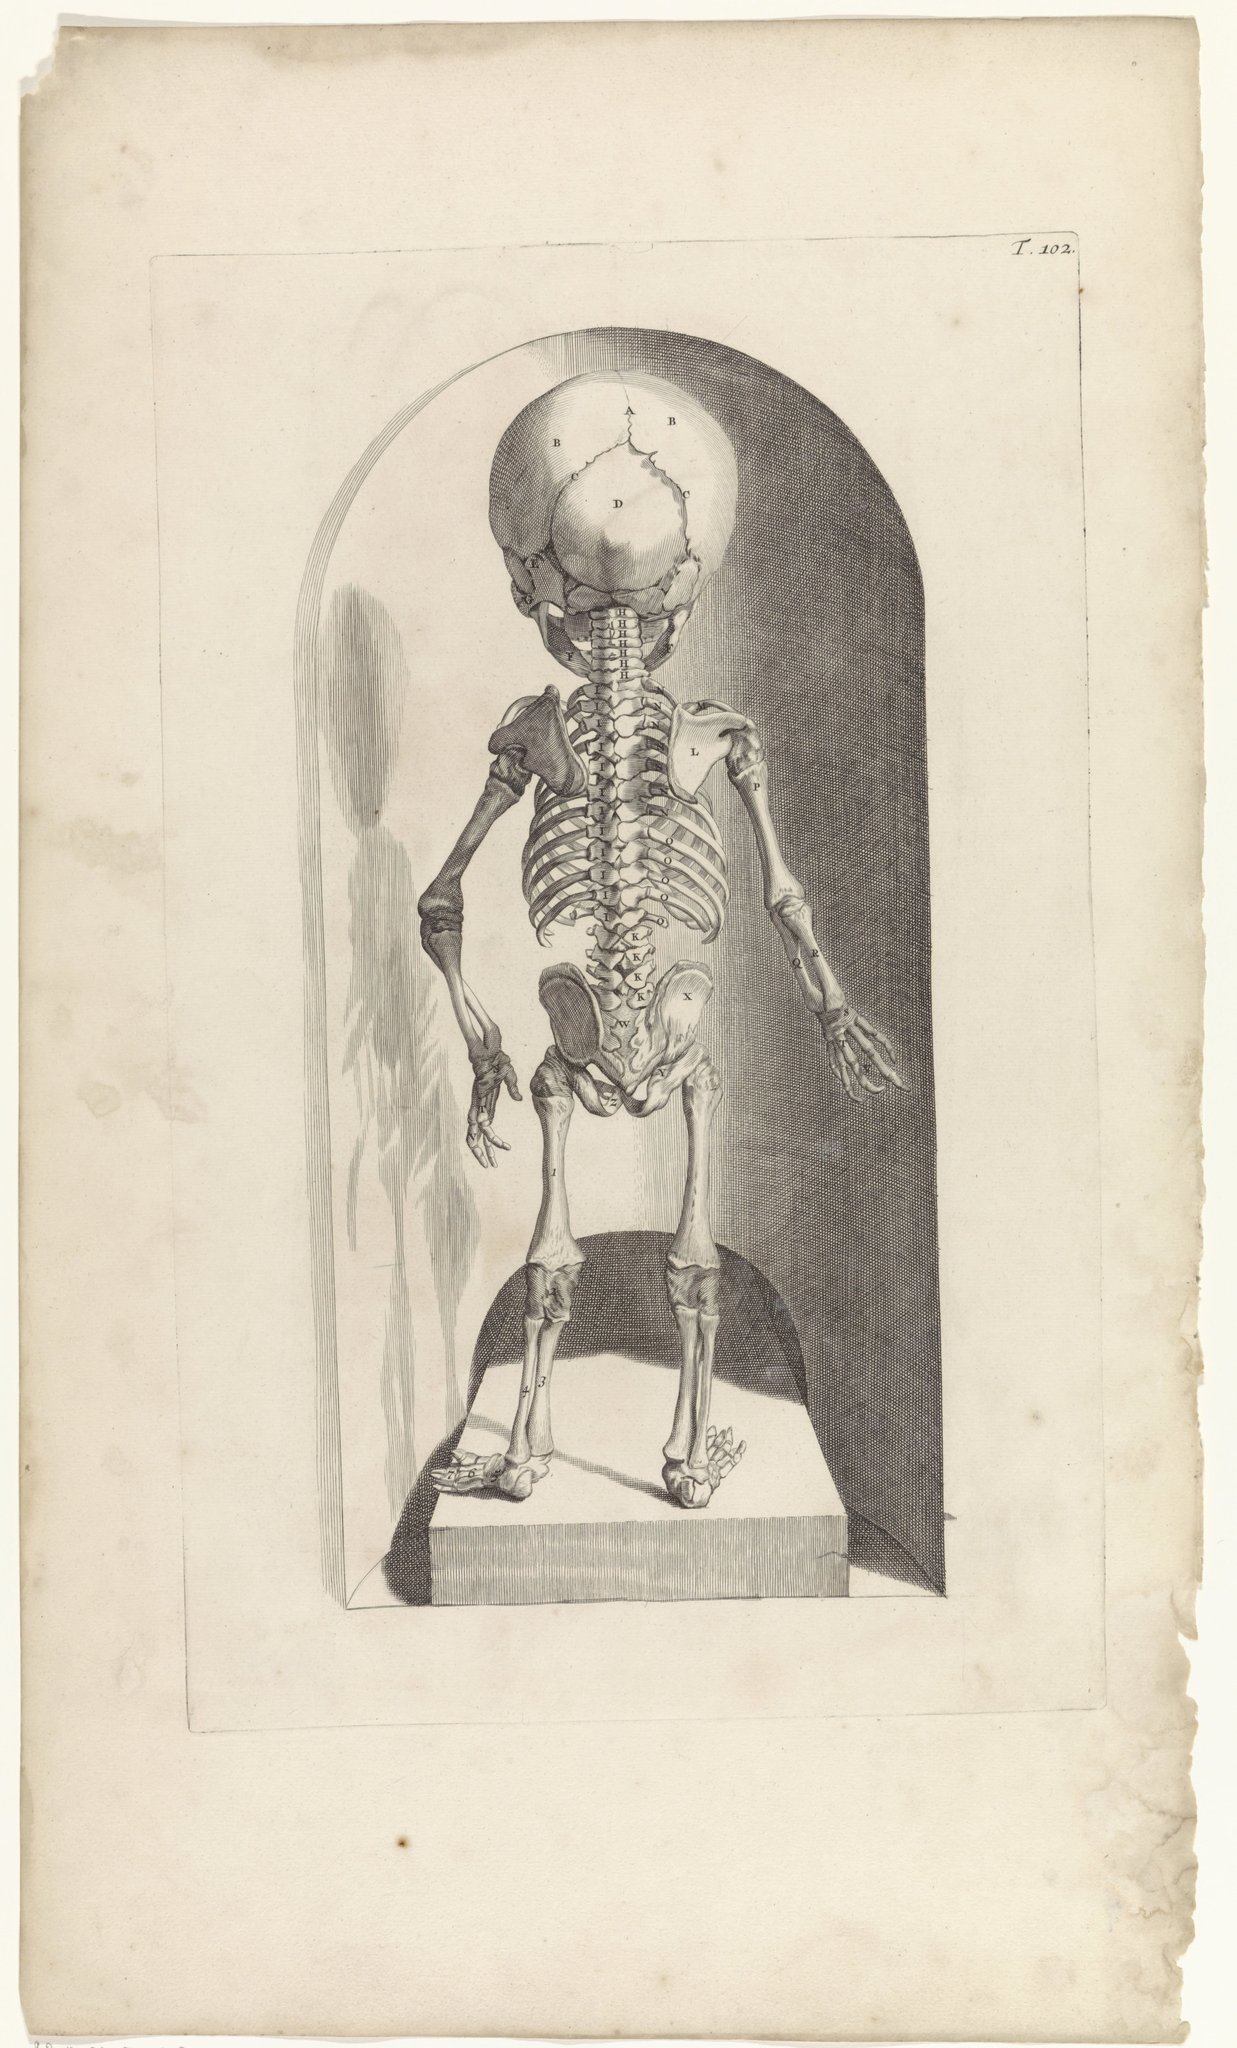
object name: print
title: Anatomische studie van het skelet van een foetus (achterkant)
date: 1685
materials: paper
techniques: engraving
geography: amsterdam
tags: (human) skeleton (+ back view), (human) skeleton (+ young male (human being)), foetus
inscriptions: collector's mark: Lugt 2228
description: Boekillustratie voor Bidloo, Godefridus. Anatomia humani corporis centum & quinque tabulis, per art. G. de Lairesse ad vivum delineatis, de monstrata, veterum recentiorumque inventis explicata plurimisque, hactenus non detectis, illustrata. Amsterdam: Weduwe Joannes van Someren, Hendrick Boom en erven Dirk Boom, 1685.